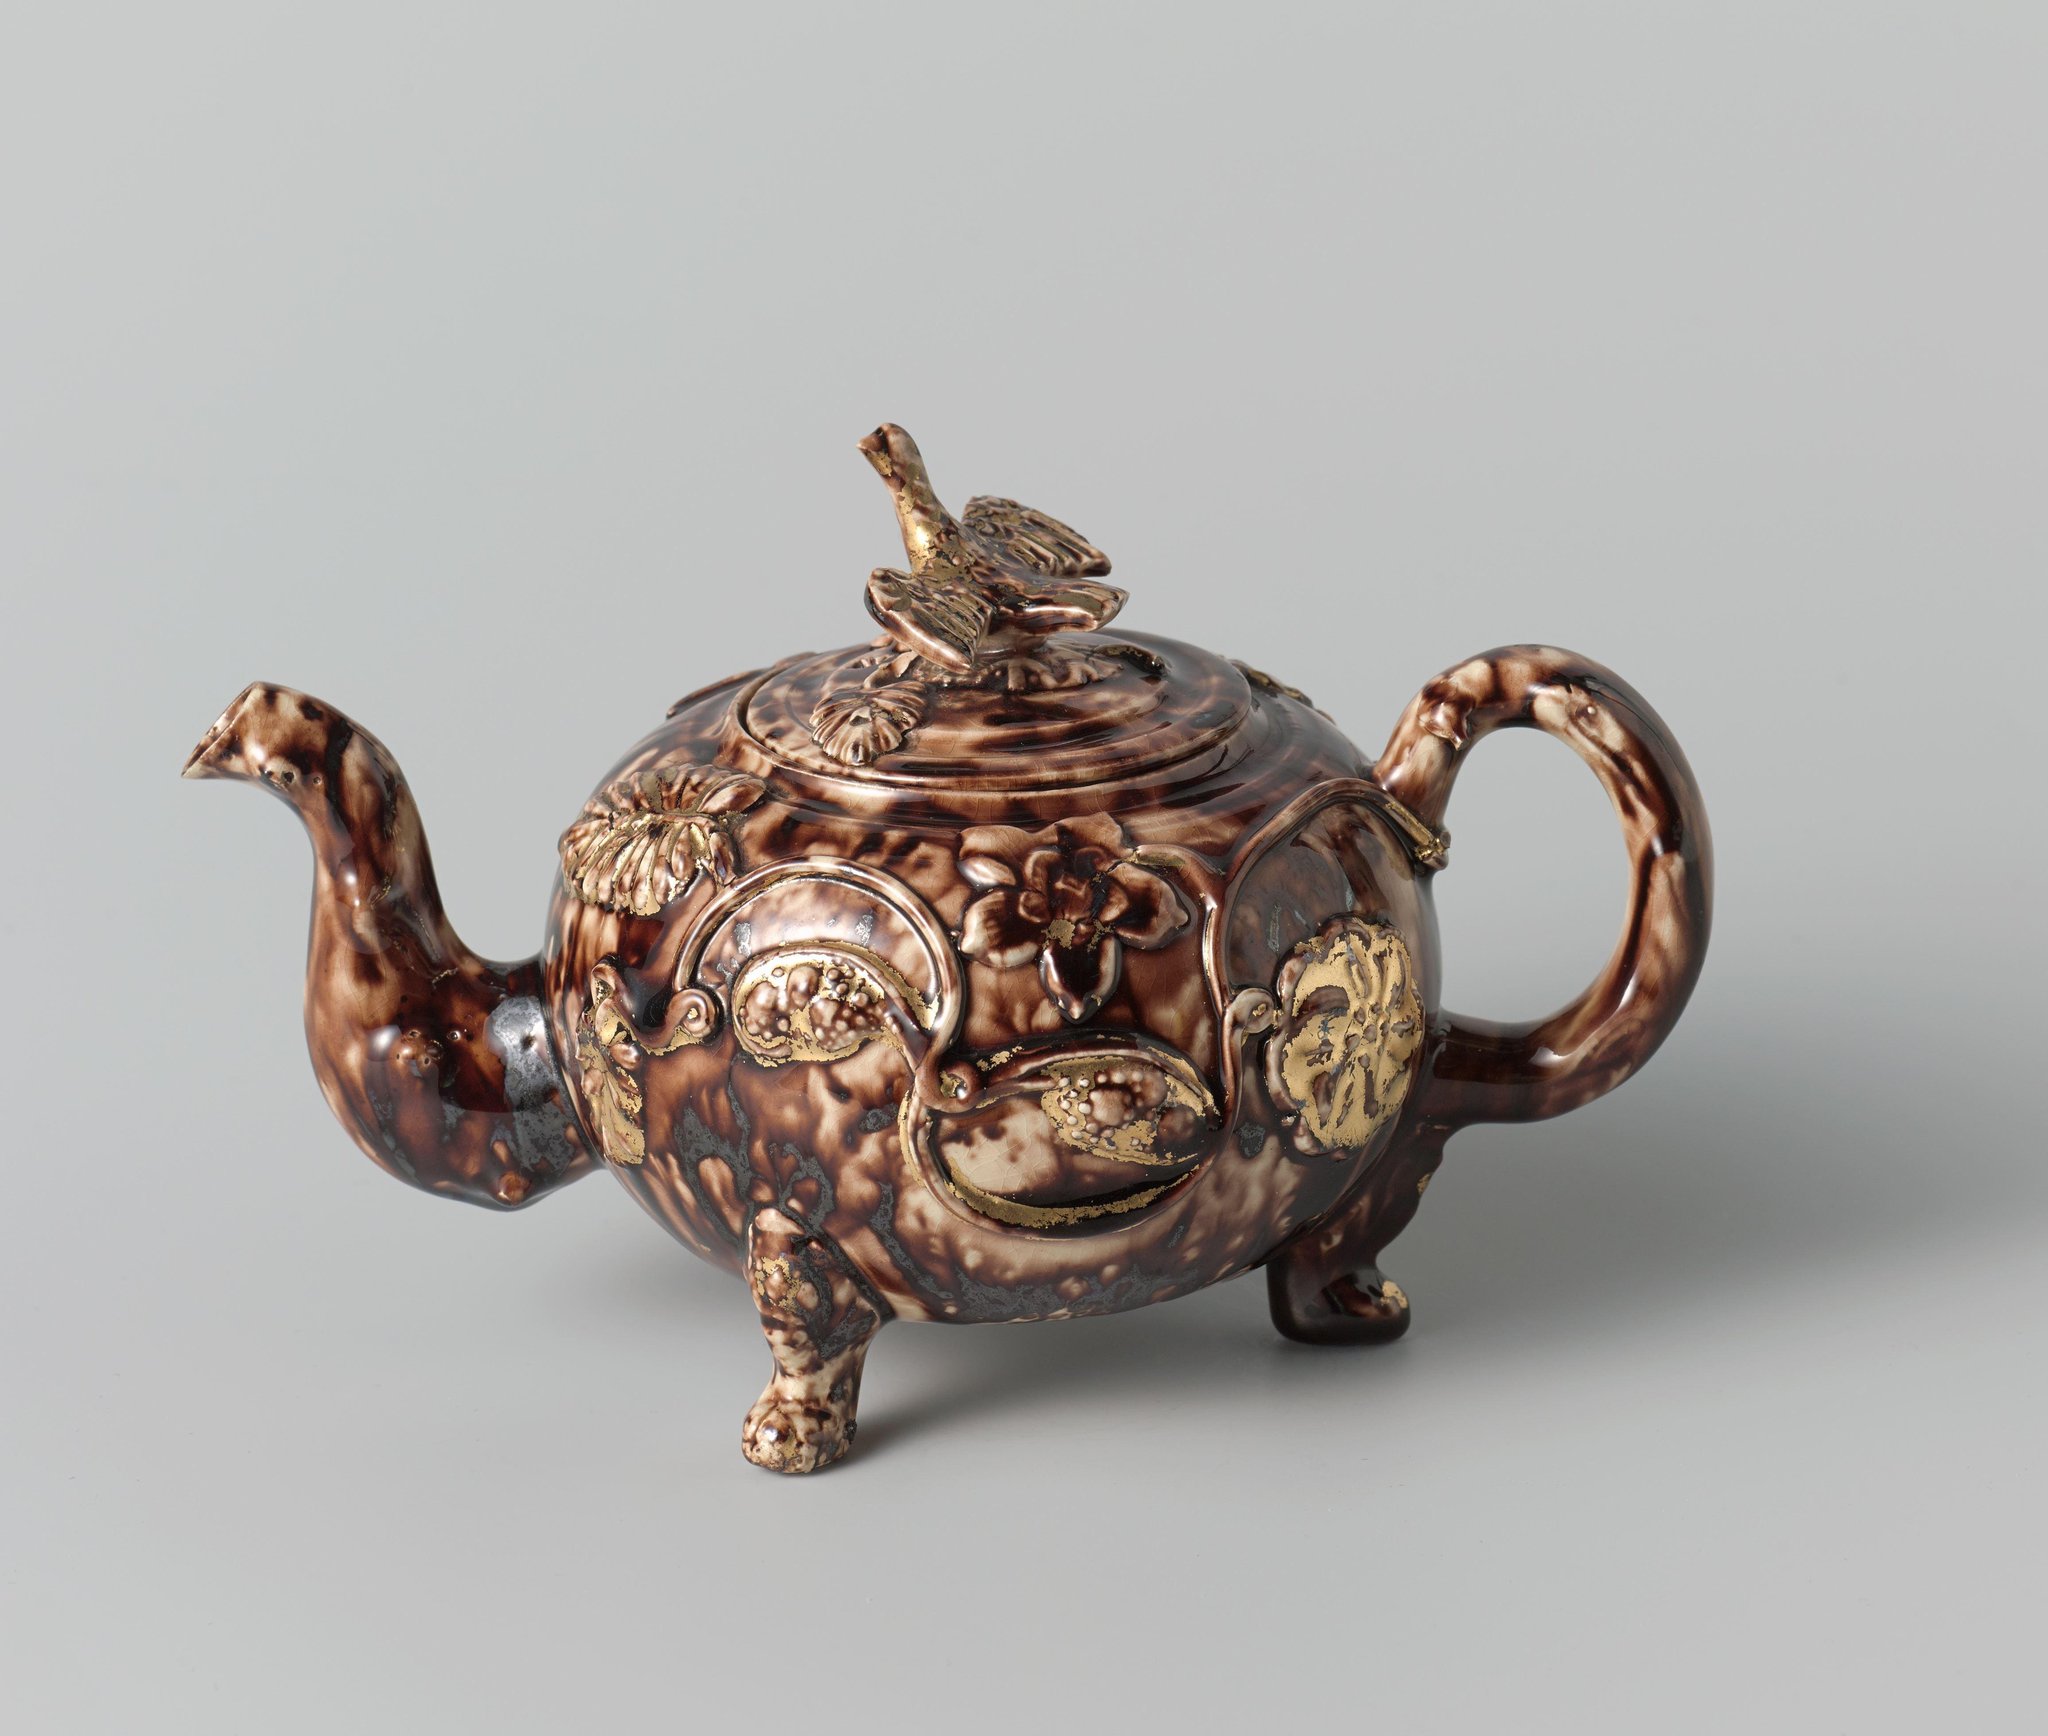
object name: lid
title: Deksel van hardgebakken aardewerk; Staffordshire.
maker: Anonymous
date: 1750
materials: earthenware, glaze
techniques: gilding, marbling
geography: england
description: Deksel van hardgebakken aardewerk. Het deksel heeft een vogel als knop.